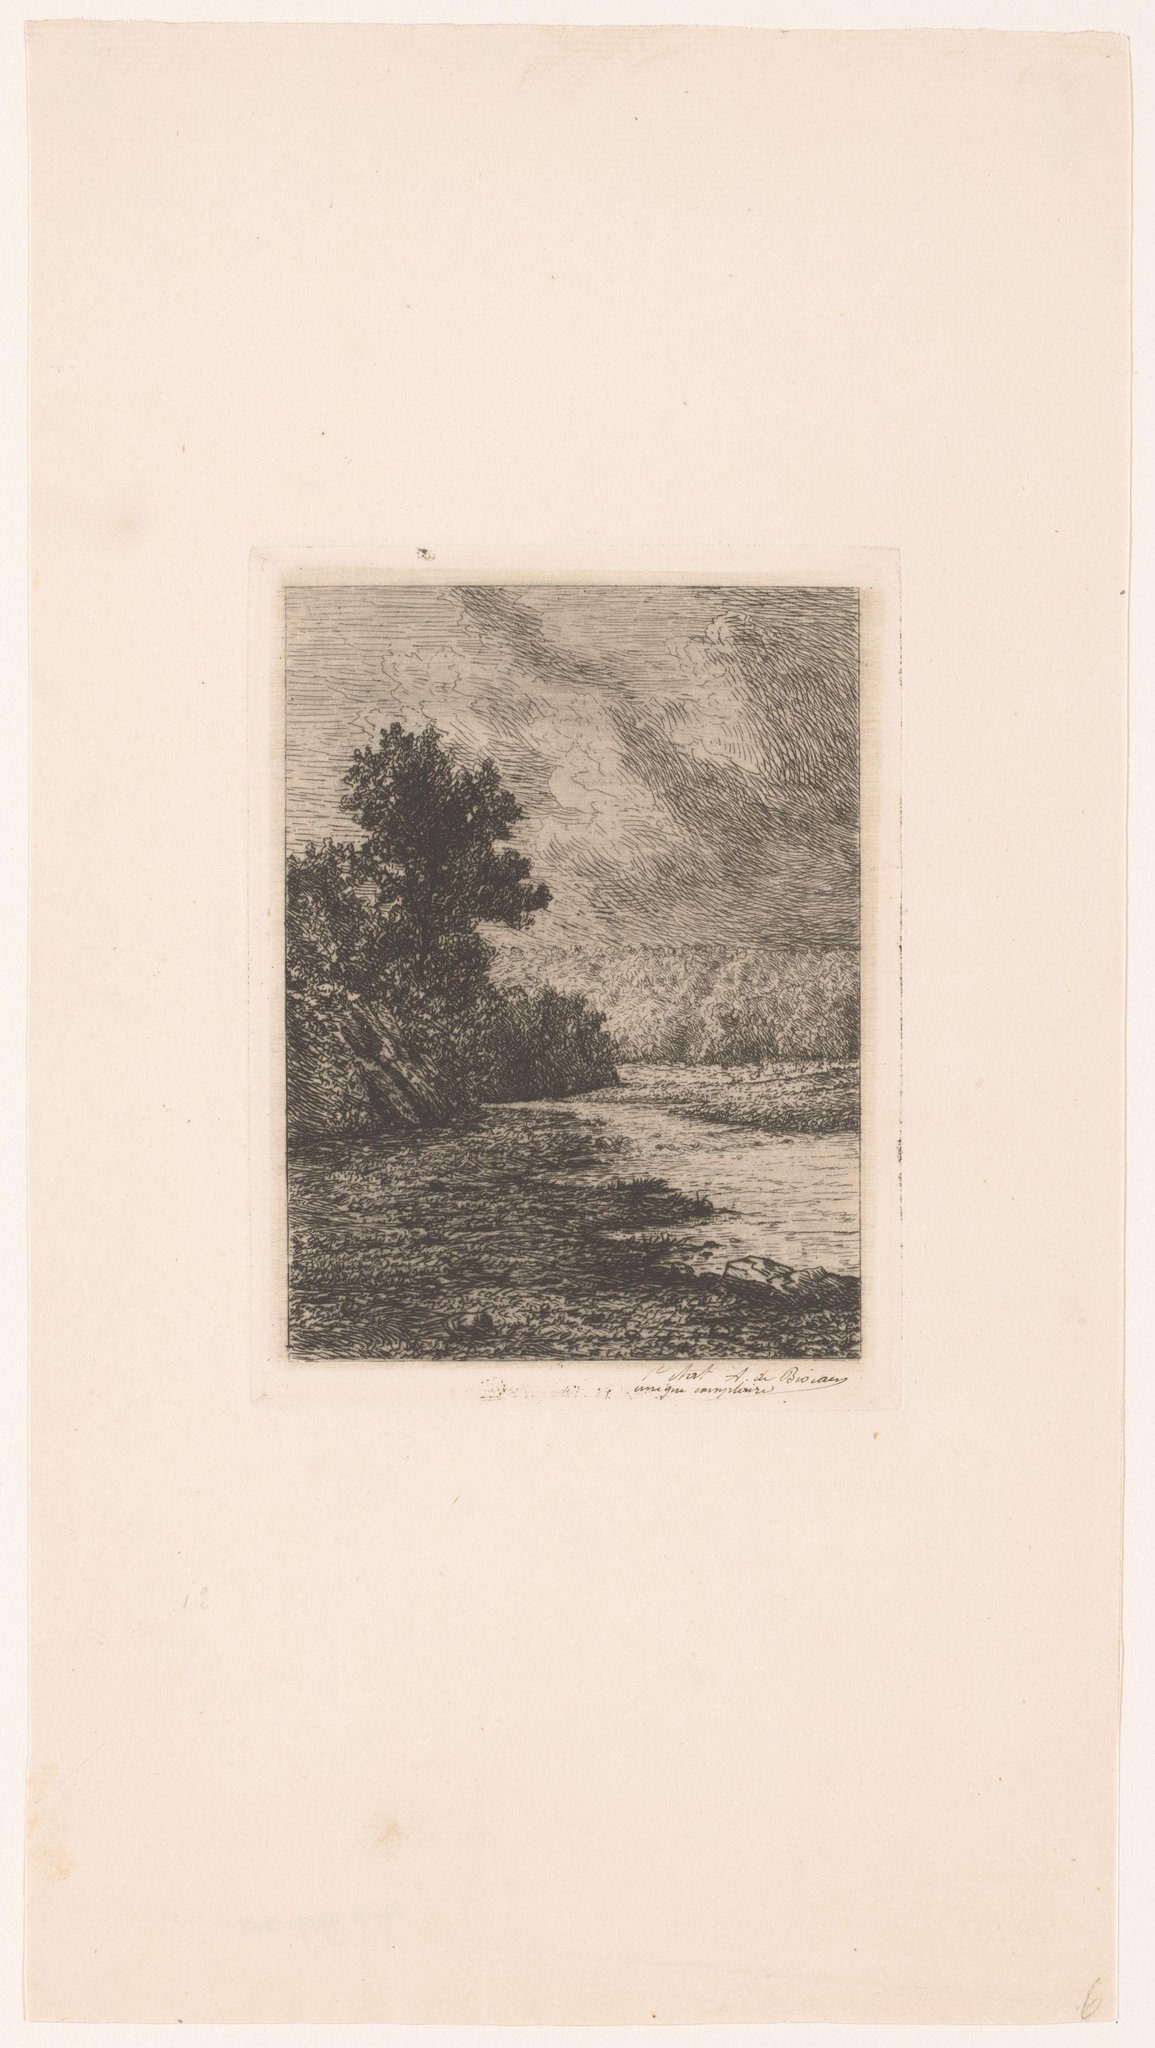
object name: print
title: Rivierlandschap bij maanlicht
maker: aristide de biseau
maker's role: print maker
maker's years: 1844-1883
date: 1854-1883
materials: paper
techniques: drypoint, etching, intaglio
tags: river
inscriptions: collector's mark: Lugt 2228, annotation: ‘1e etat unique exemplaire’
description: Gezien de annotatie onder de prent waarschijnlijk de enige afdruk van deze eerste staat.